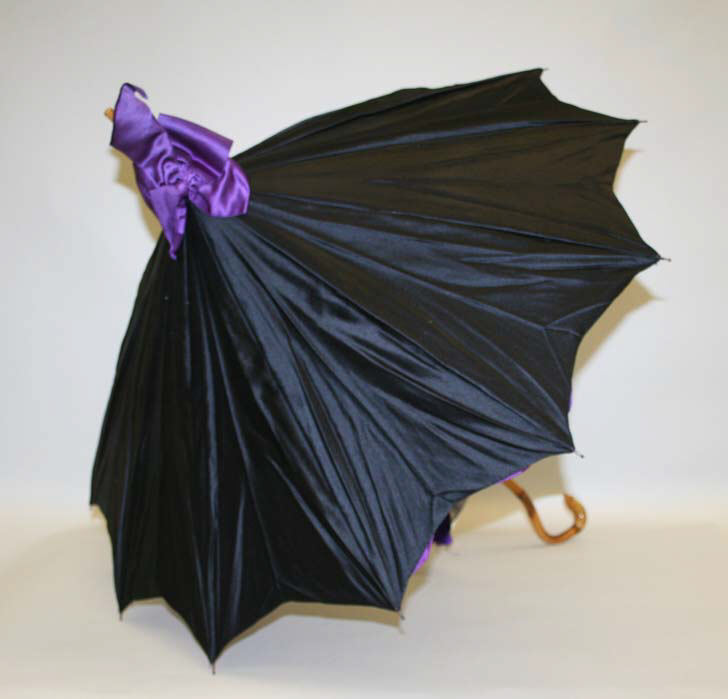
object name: parasol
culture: american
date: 1890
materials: silk